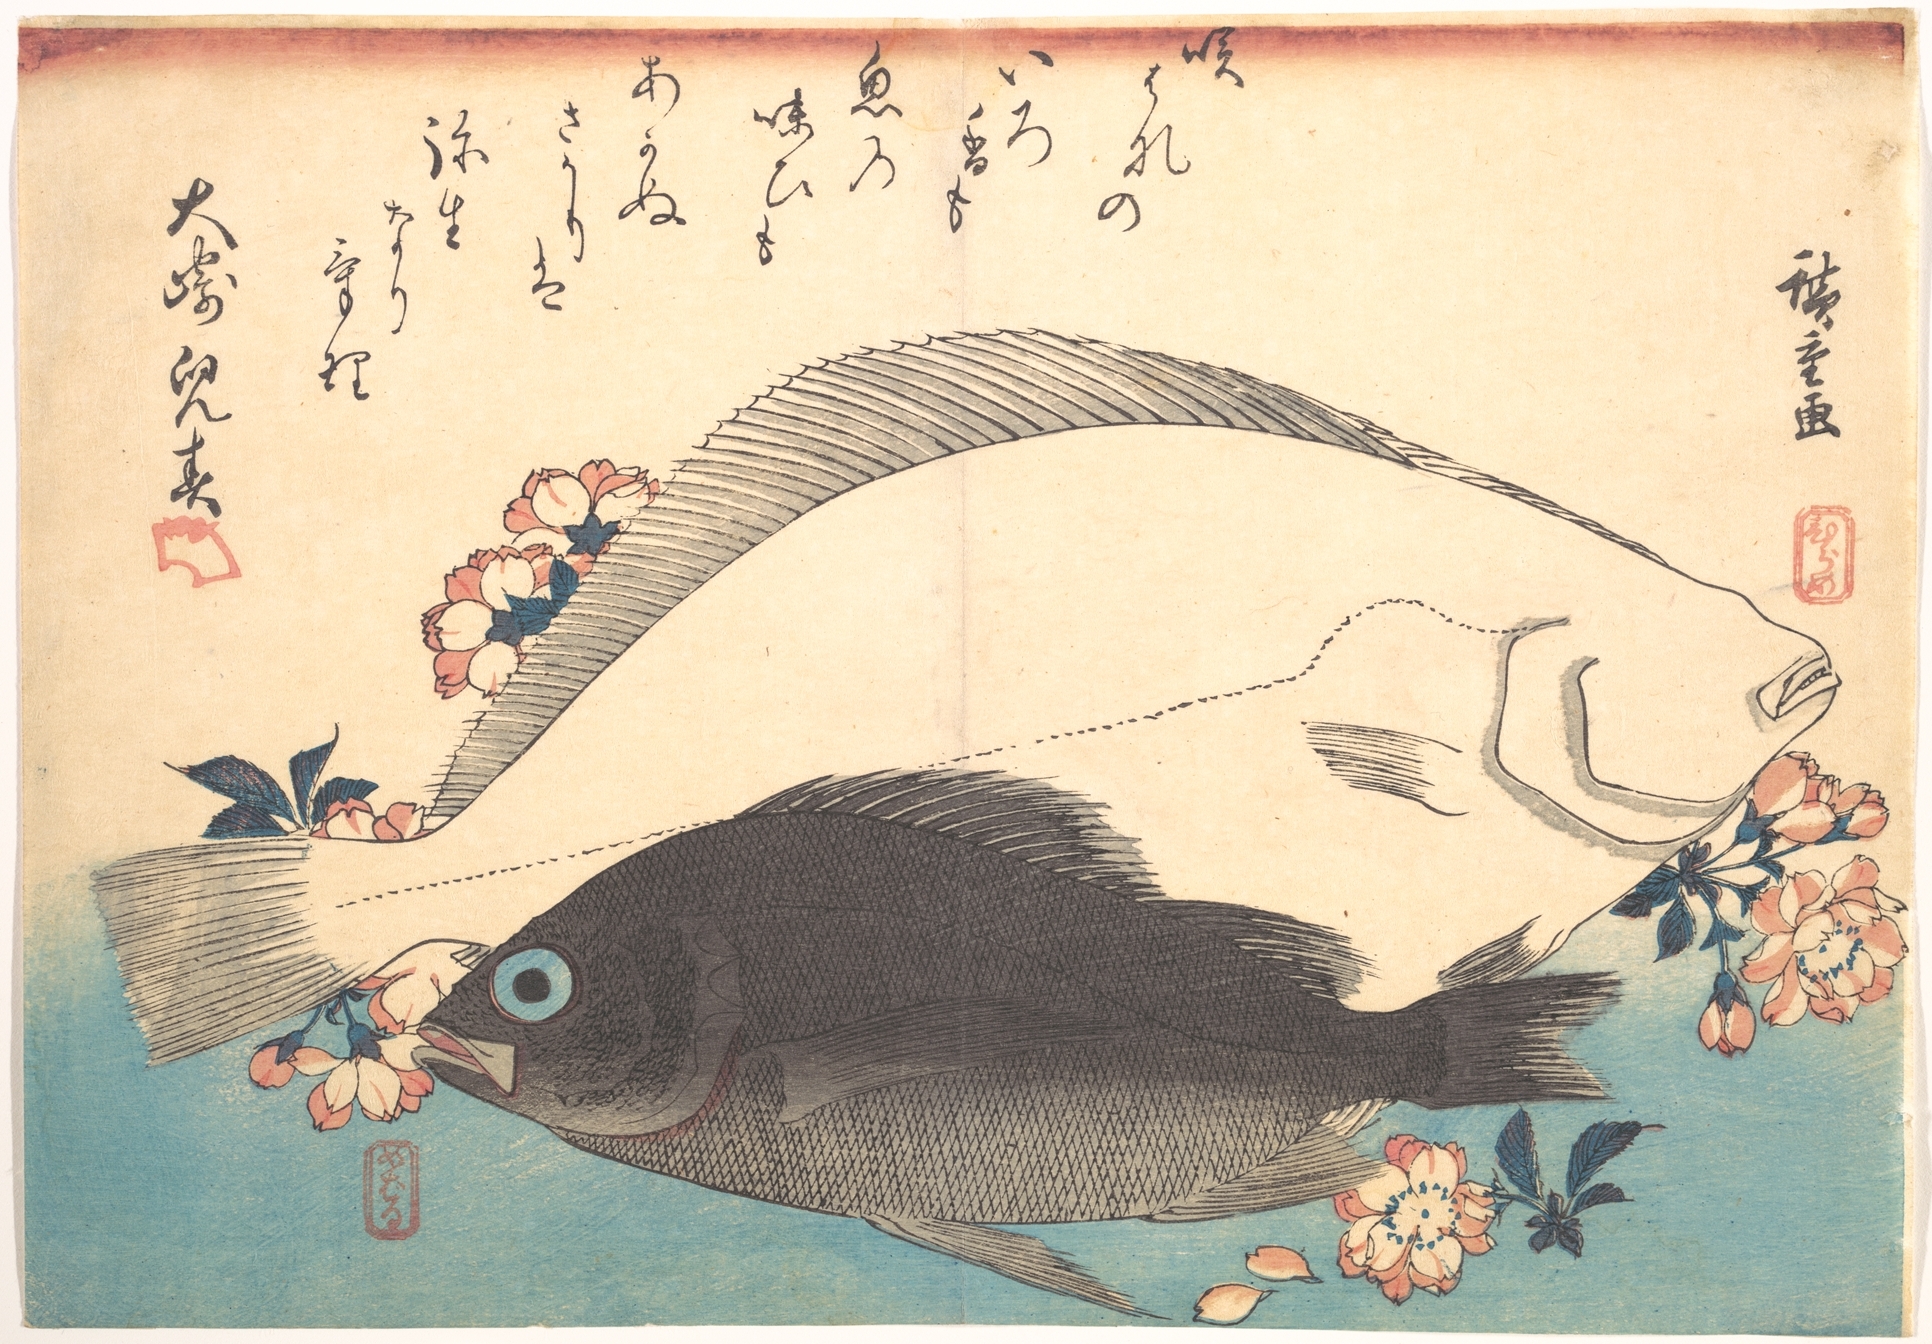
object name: woodblock print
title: Hirame and Mebaru Fish with Cherry Blossoms, from the series Uozukushi (Every Variety of Fish)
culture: japanese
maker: utagawa hiroshige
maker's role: artist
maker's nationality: japanese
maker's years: 1797-1858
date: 1840-1849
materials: ink, paper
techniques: woodblock print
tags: fish,flowers